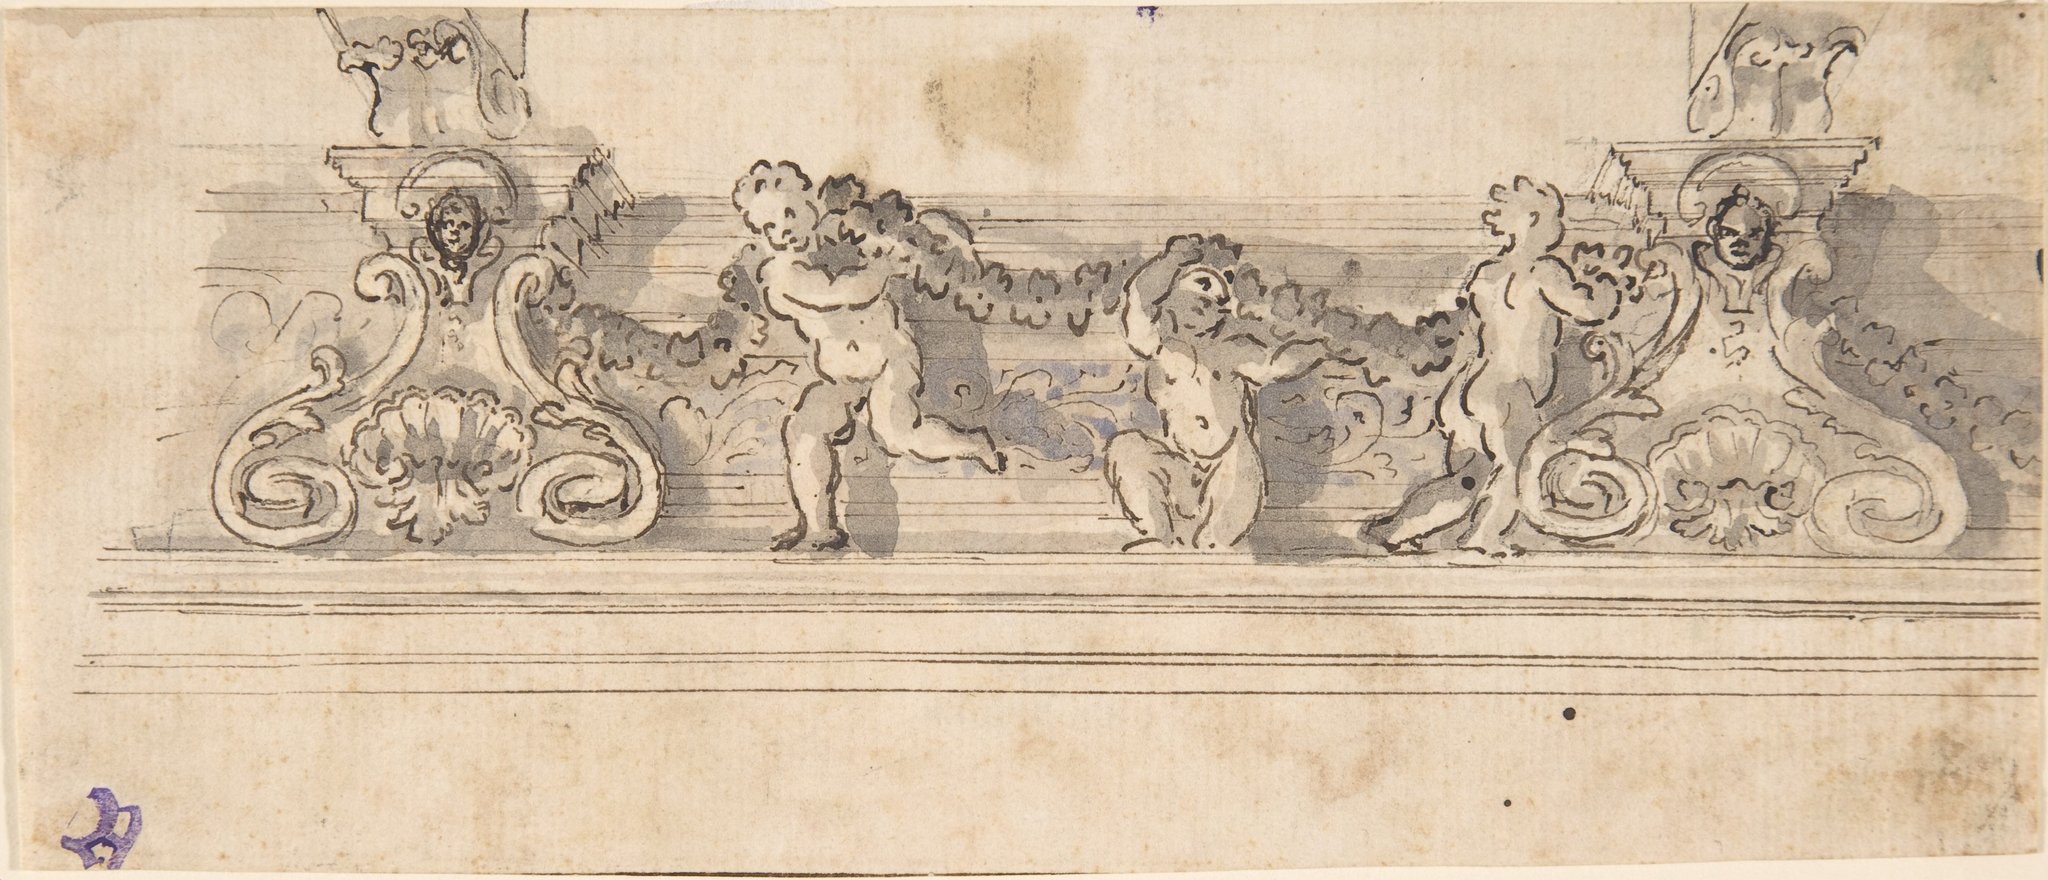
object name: drawing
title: Design for the Decoration of a Cornice with Putti holding a Garland (recto); Red Chalk Sketches (verso)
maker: anonymous, italian, 17th century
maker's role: artist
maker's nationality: italian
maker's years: 1600-1700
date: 1601-1700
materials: chalk, ink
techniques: brush, pen, wash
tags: garlands,putti